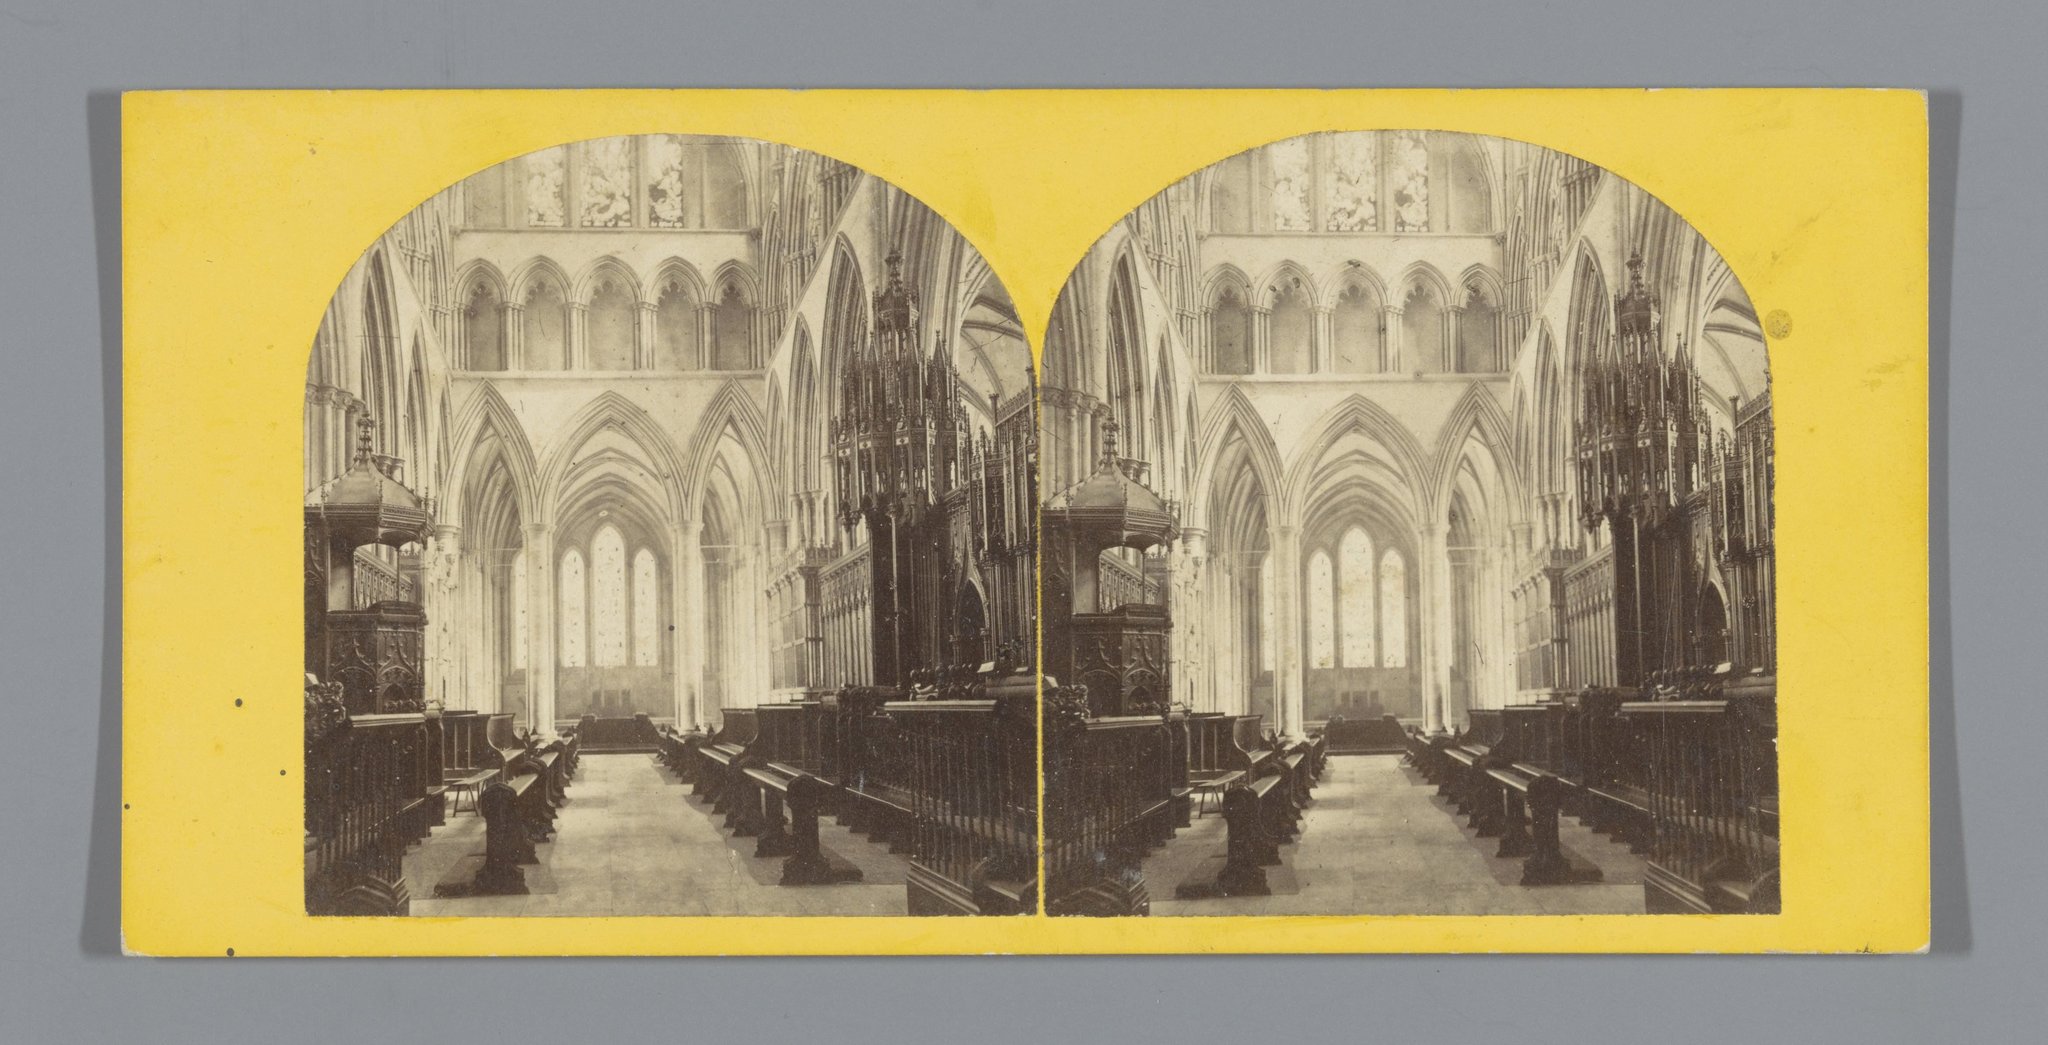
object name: stereograph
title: Interieur van de kathedraal van Salisbury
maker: Anonymous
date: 1850-1875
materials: cardboard, photographic support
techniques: albumen print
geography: salisbury cathedral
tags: interior of church, pulpit, ambo, chancel